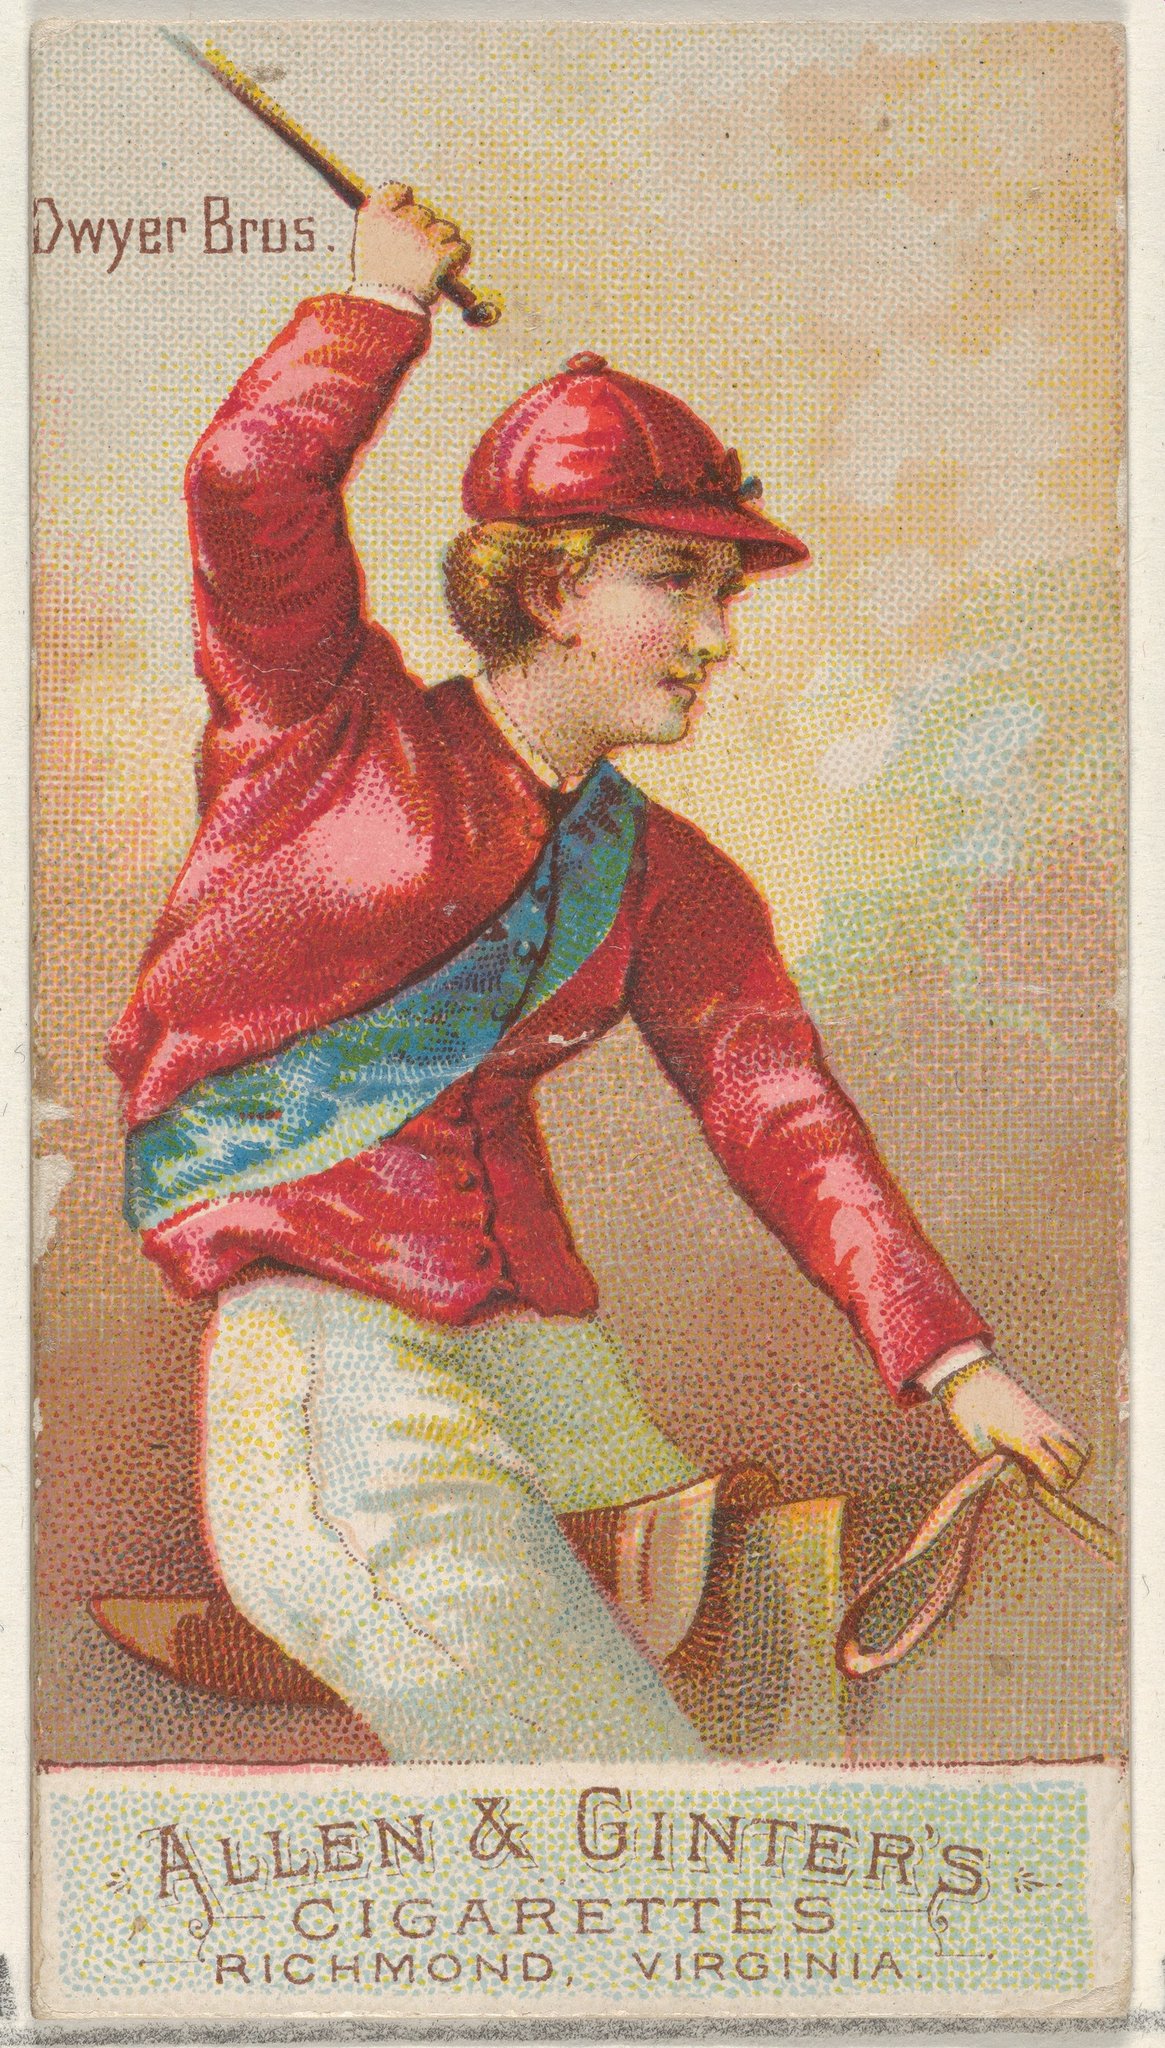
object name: print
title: Dwyer Brothers, from the Racing Colors of the World series (N22b) for Allen & Ginter Cigarettes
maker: allen & ginter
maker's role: publisher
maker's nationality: american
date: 1888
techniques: color lithograph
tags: men,jockeys